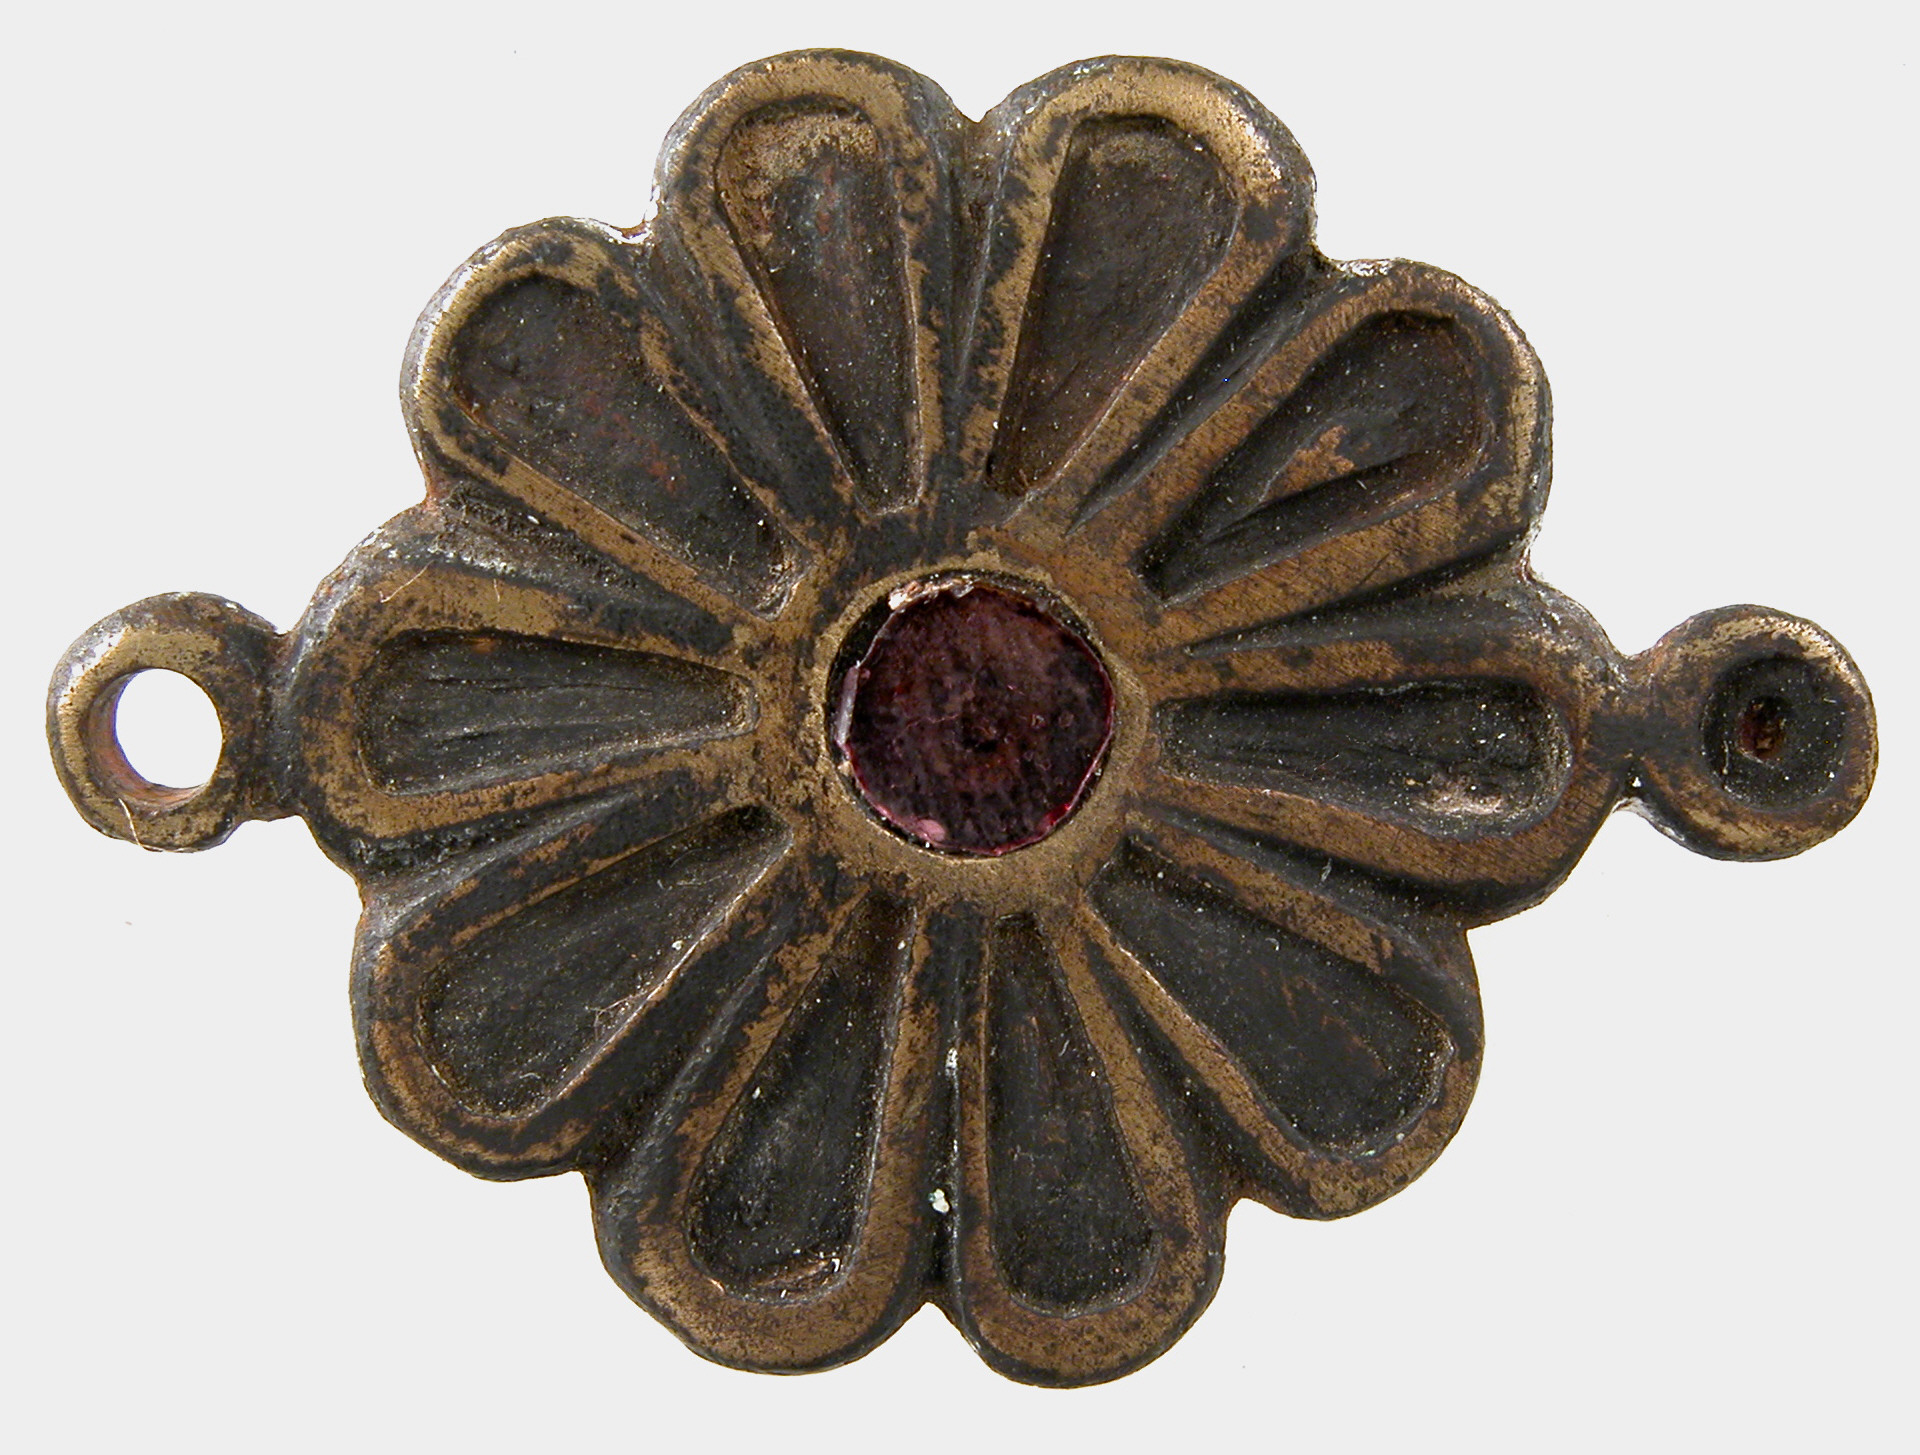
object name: brooch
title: Disk Brooch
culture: roman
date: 200-500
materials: copper alloy, gemstone, glass